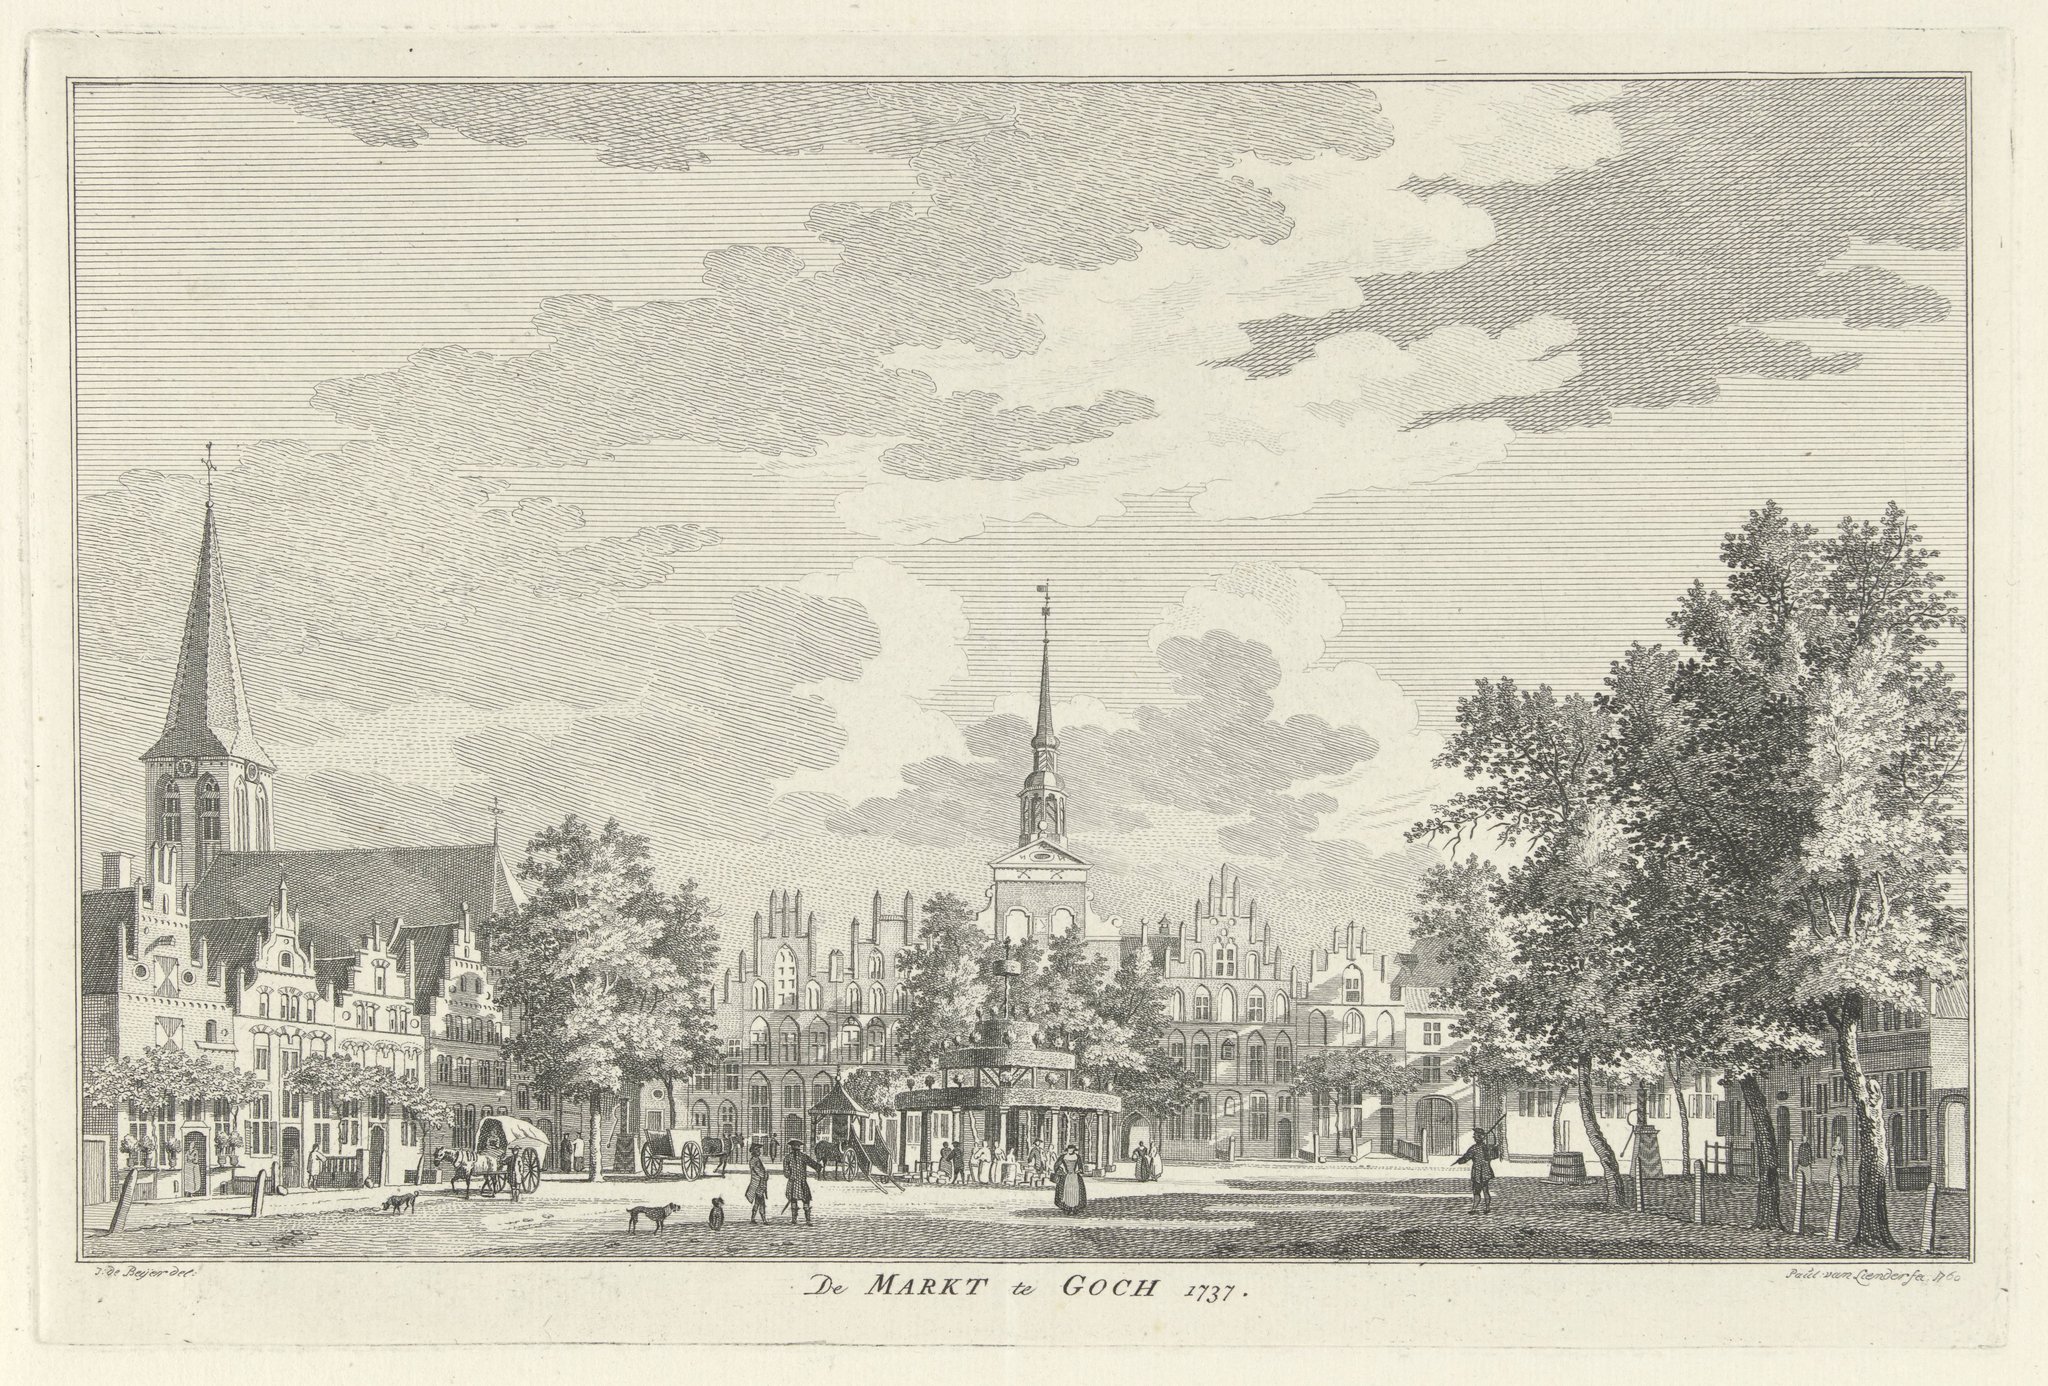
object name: print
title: De Markt te Goch 1737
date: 1760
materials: paper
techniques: etching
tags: square, place, circus, etc., market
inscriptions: collector's mark: Lugt 240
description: Gezicht op het marktplein in het centrum van de Duitse stad Goch.